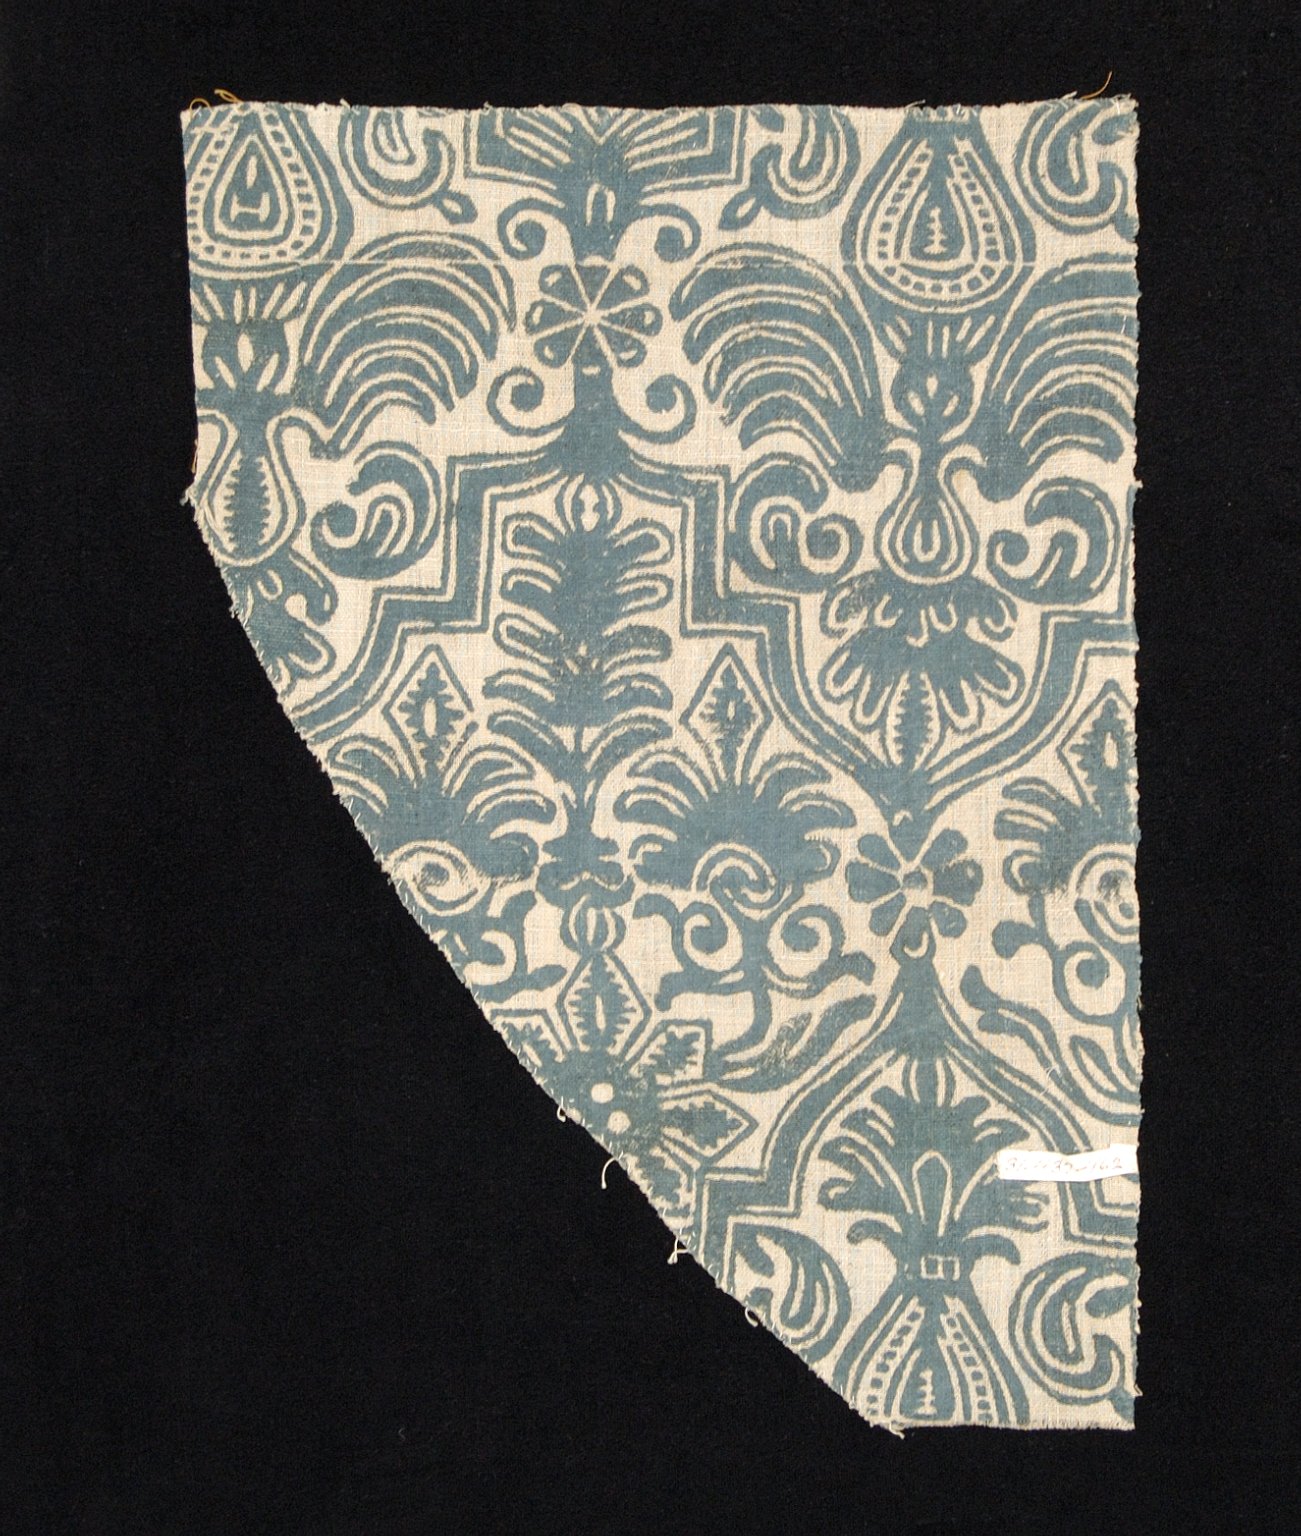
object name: textile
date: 1700-1899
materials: linen